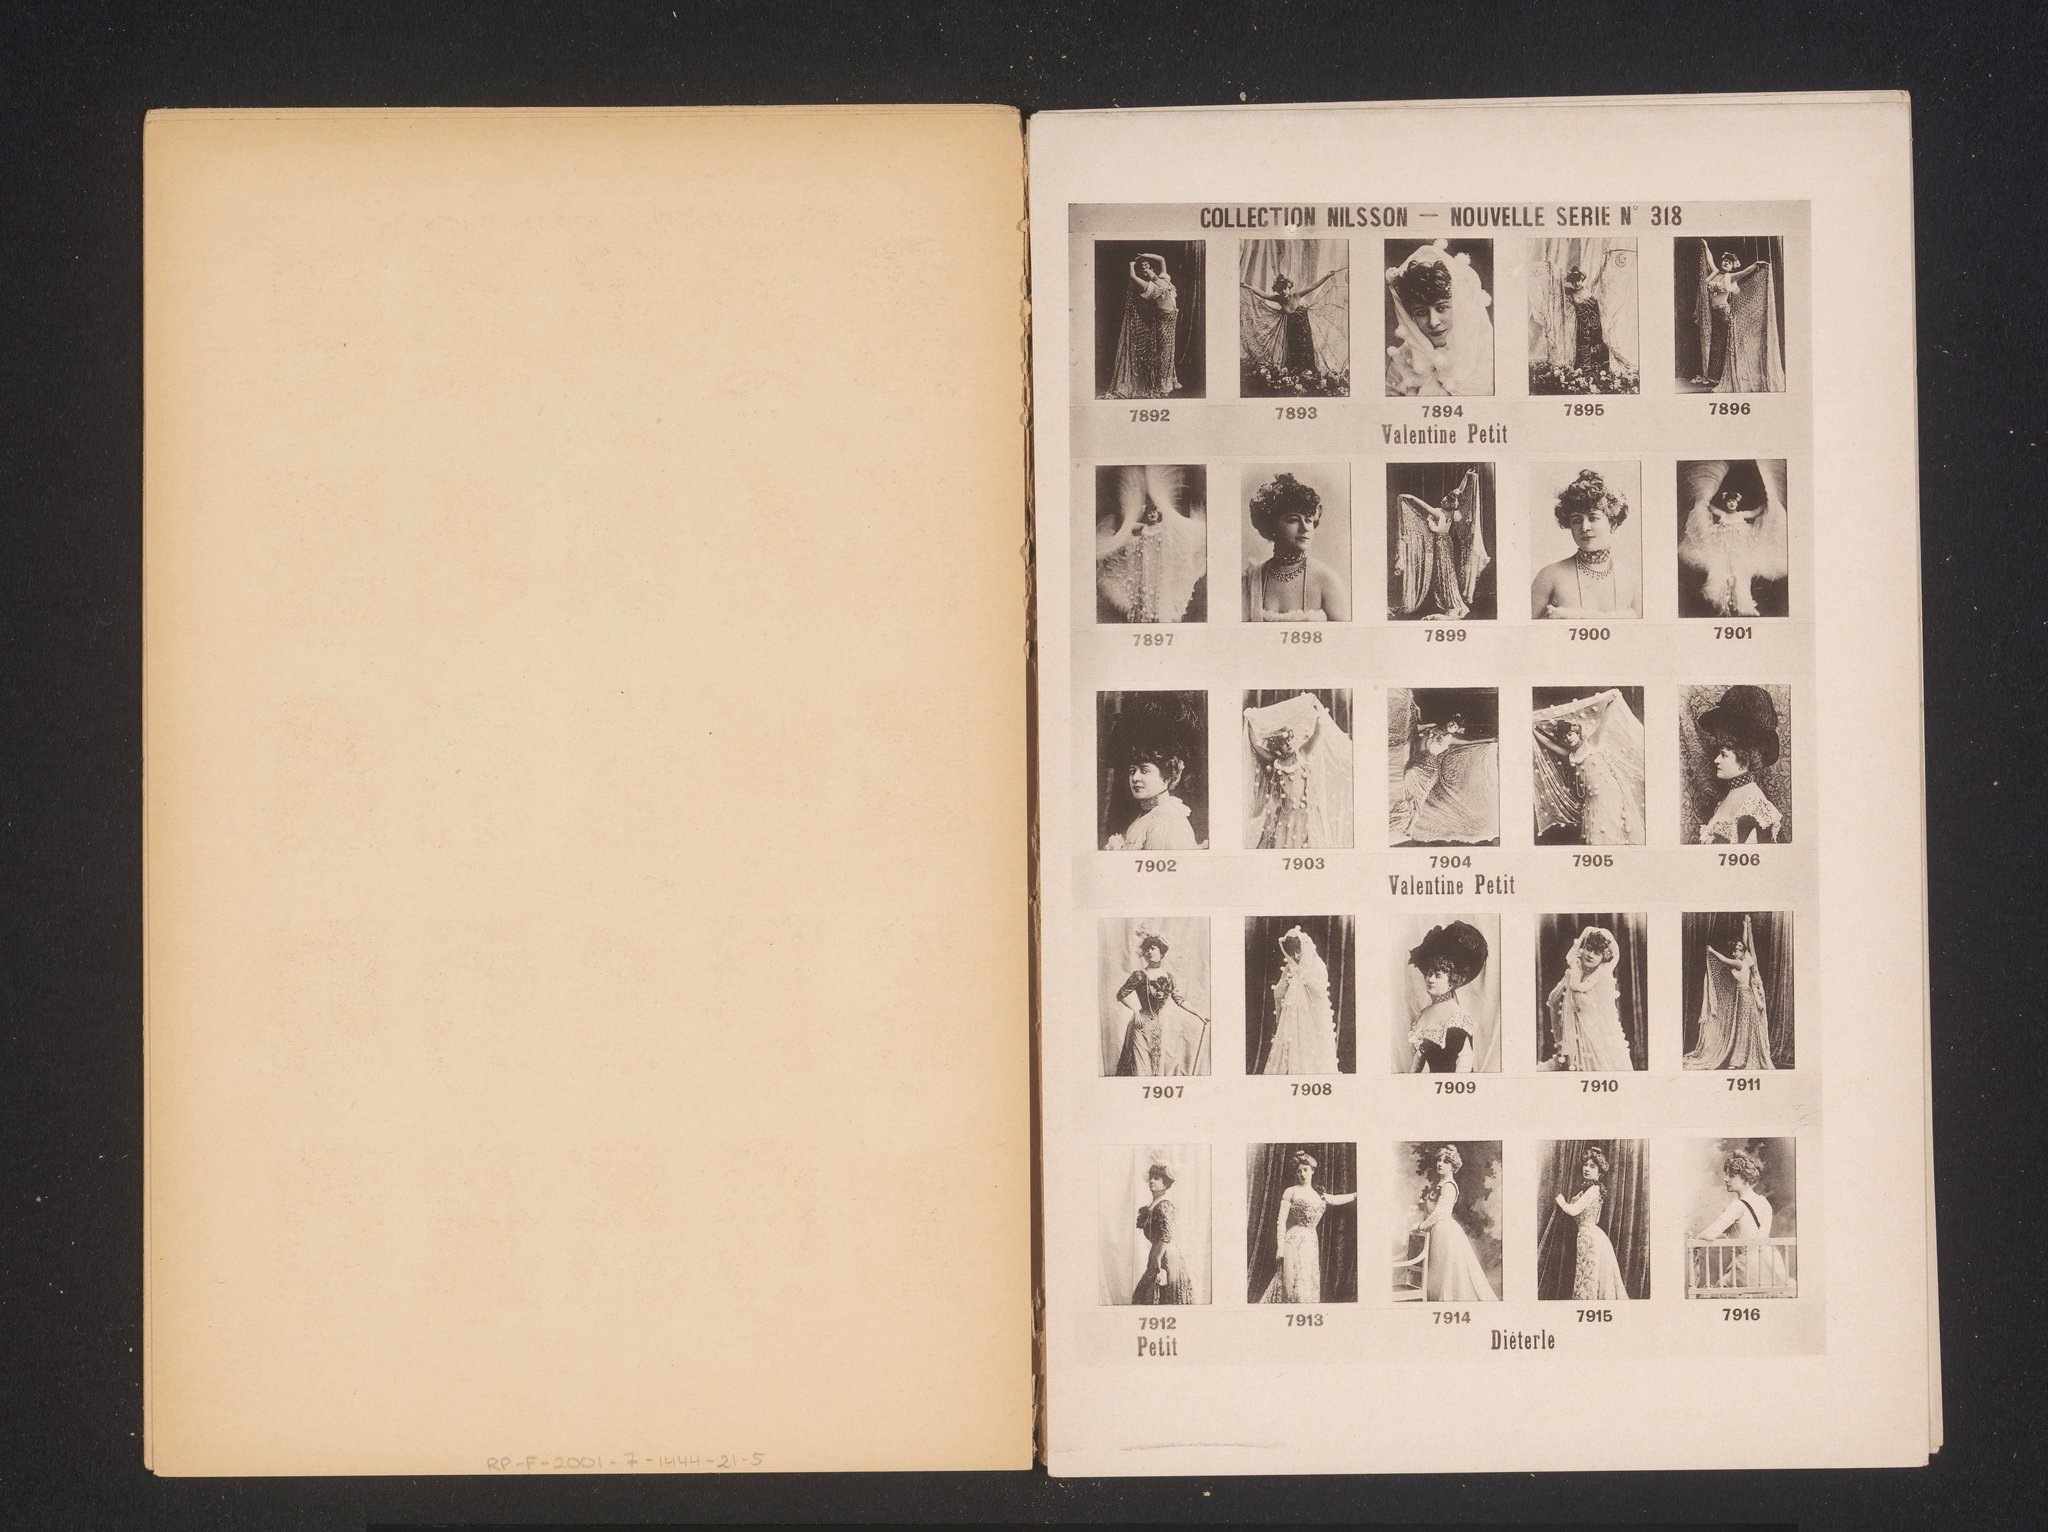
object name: page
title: 25 portretten van Valentine Petit en Diéterle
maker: Anonymous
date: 1895-1900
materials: paper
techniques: photograph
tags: historical persons - bb - woman, portrait of actor, actress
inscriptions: number: ‘No 318’